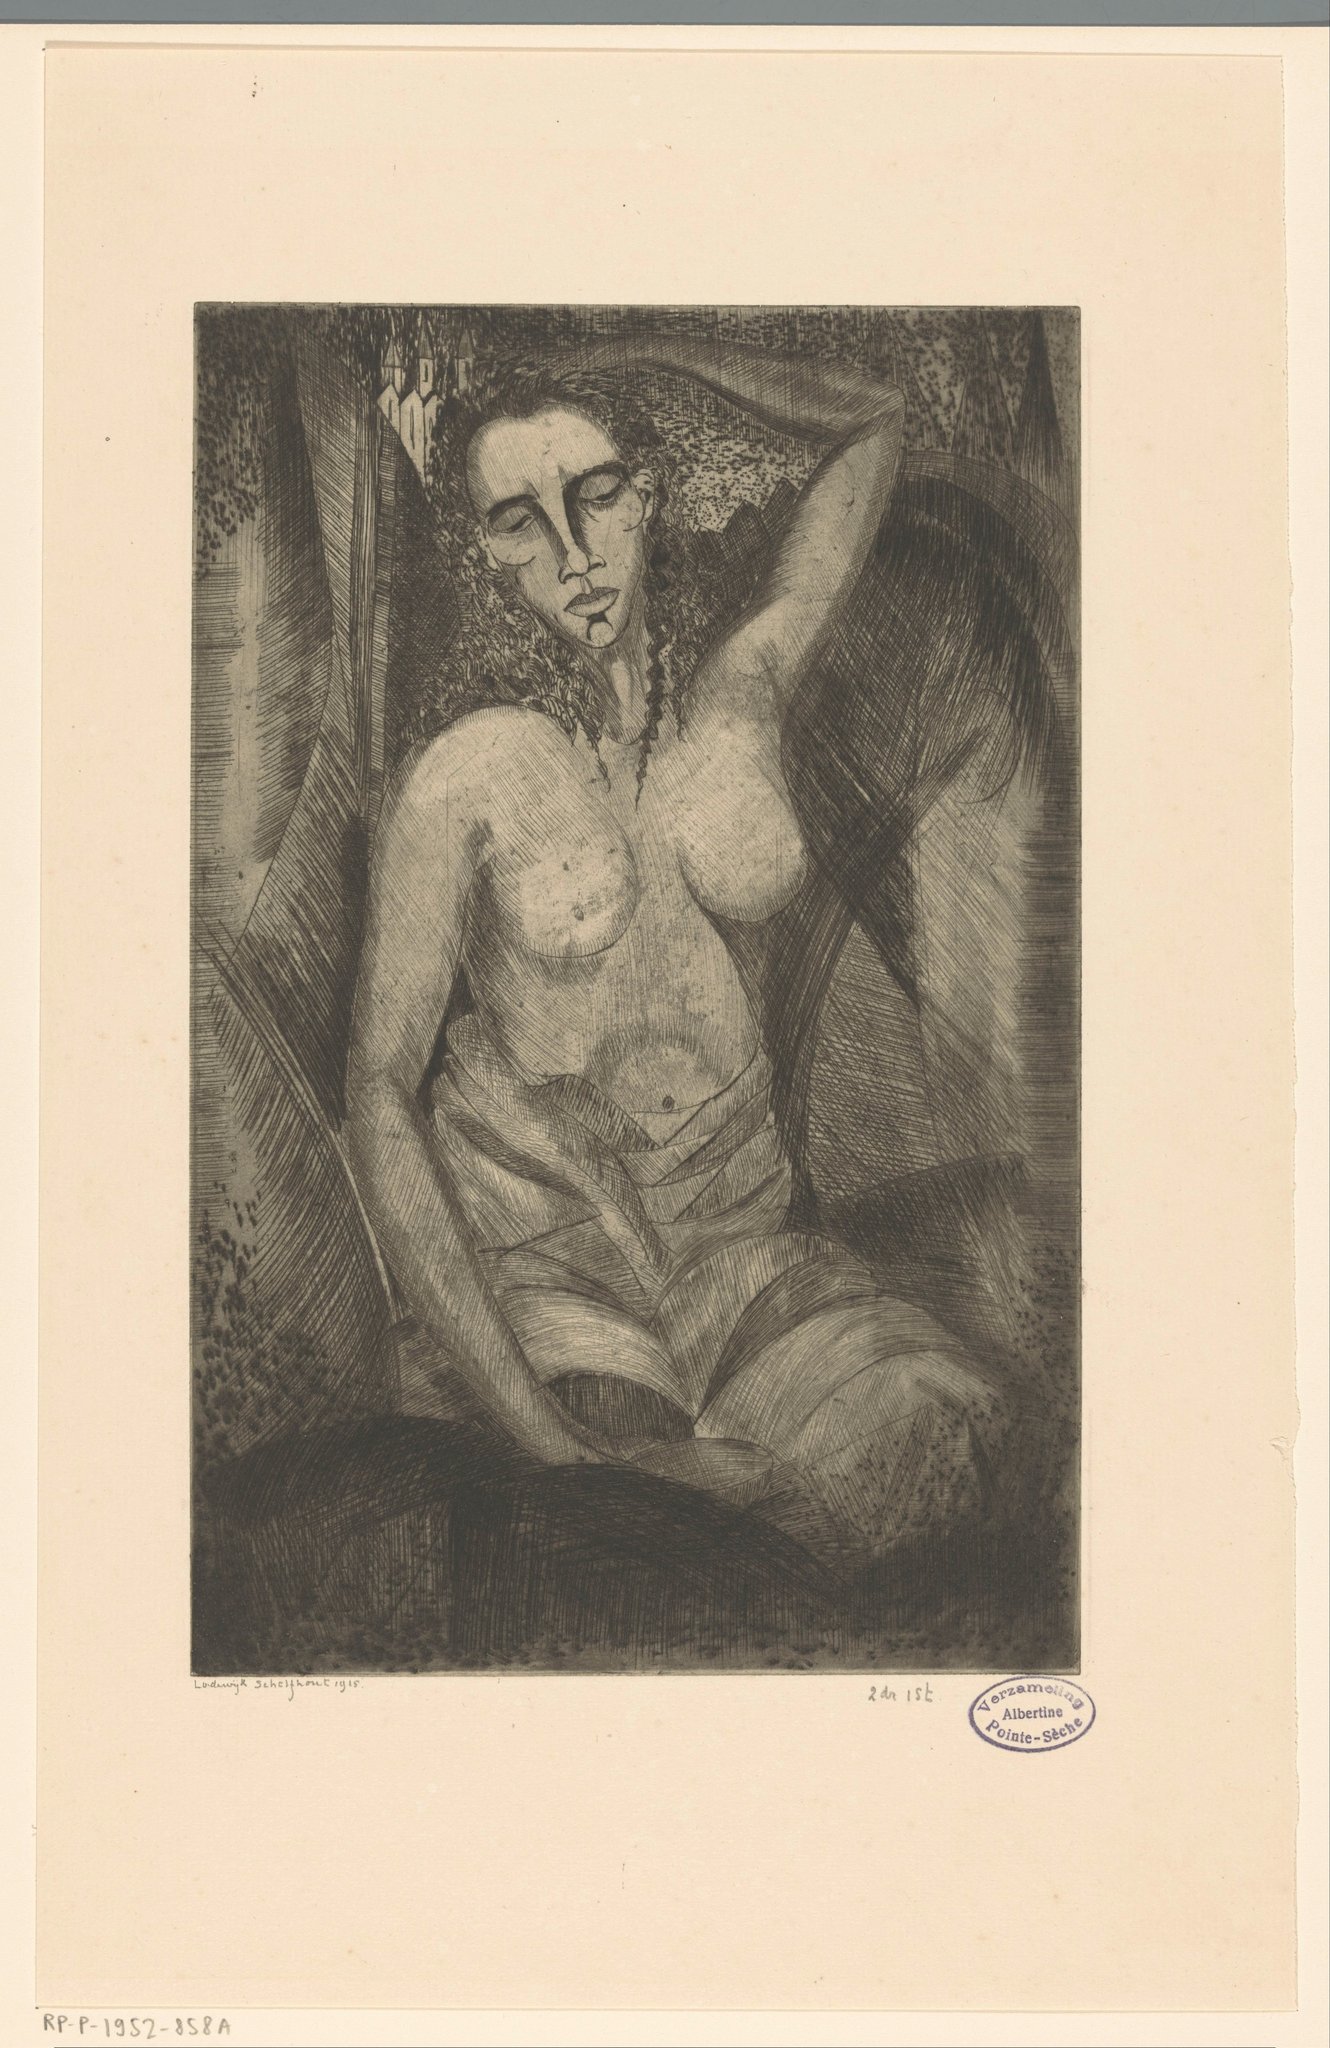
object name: print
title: Zittende vrouw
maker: lodewijk schelfhout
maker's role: draughtsman, print maker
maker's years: 1881-1943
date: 1915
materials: paper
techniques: drypoint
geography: netherlands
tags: sitting figure - aa - female human figure, hand behind the head, woman (showing herself) undressed, quasi-nude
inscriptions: collector's mark: Lugt 2228, collector's mark: Lugt 2760, collector's mark: Lugt 5i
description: Een zittende vrouw met naakt bovenlijf. Ze raakt haar achterhoofd met haar linkerhand aan.